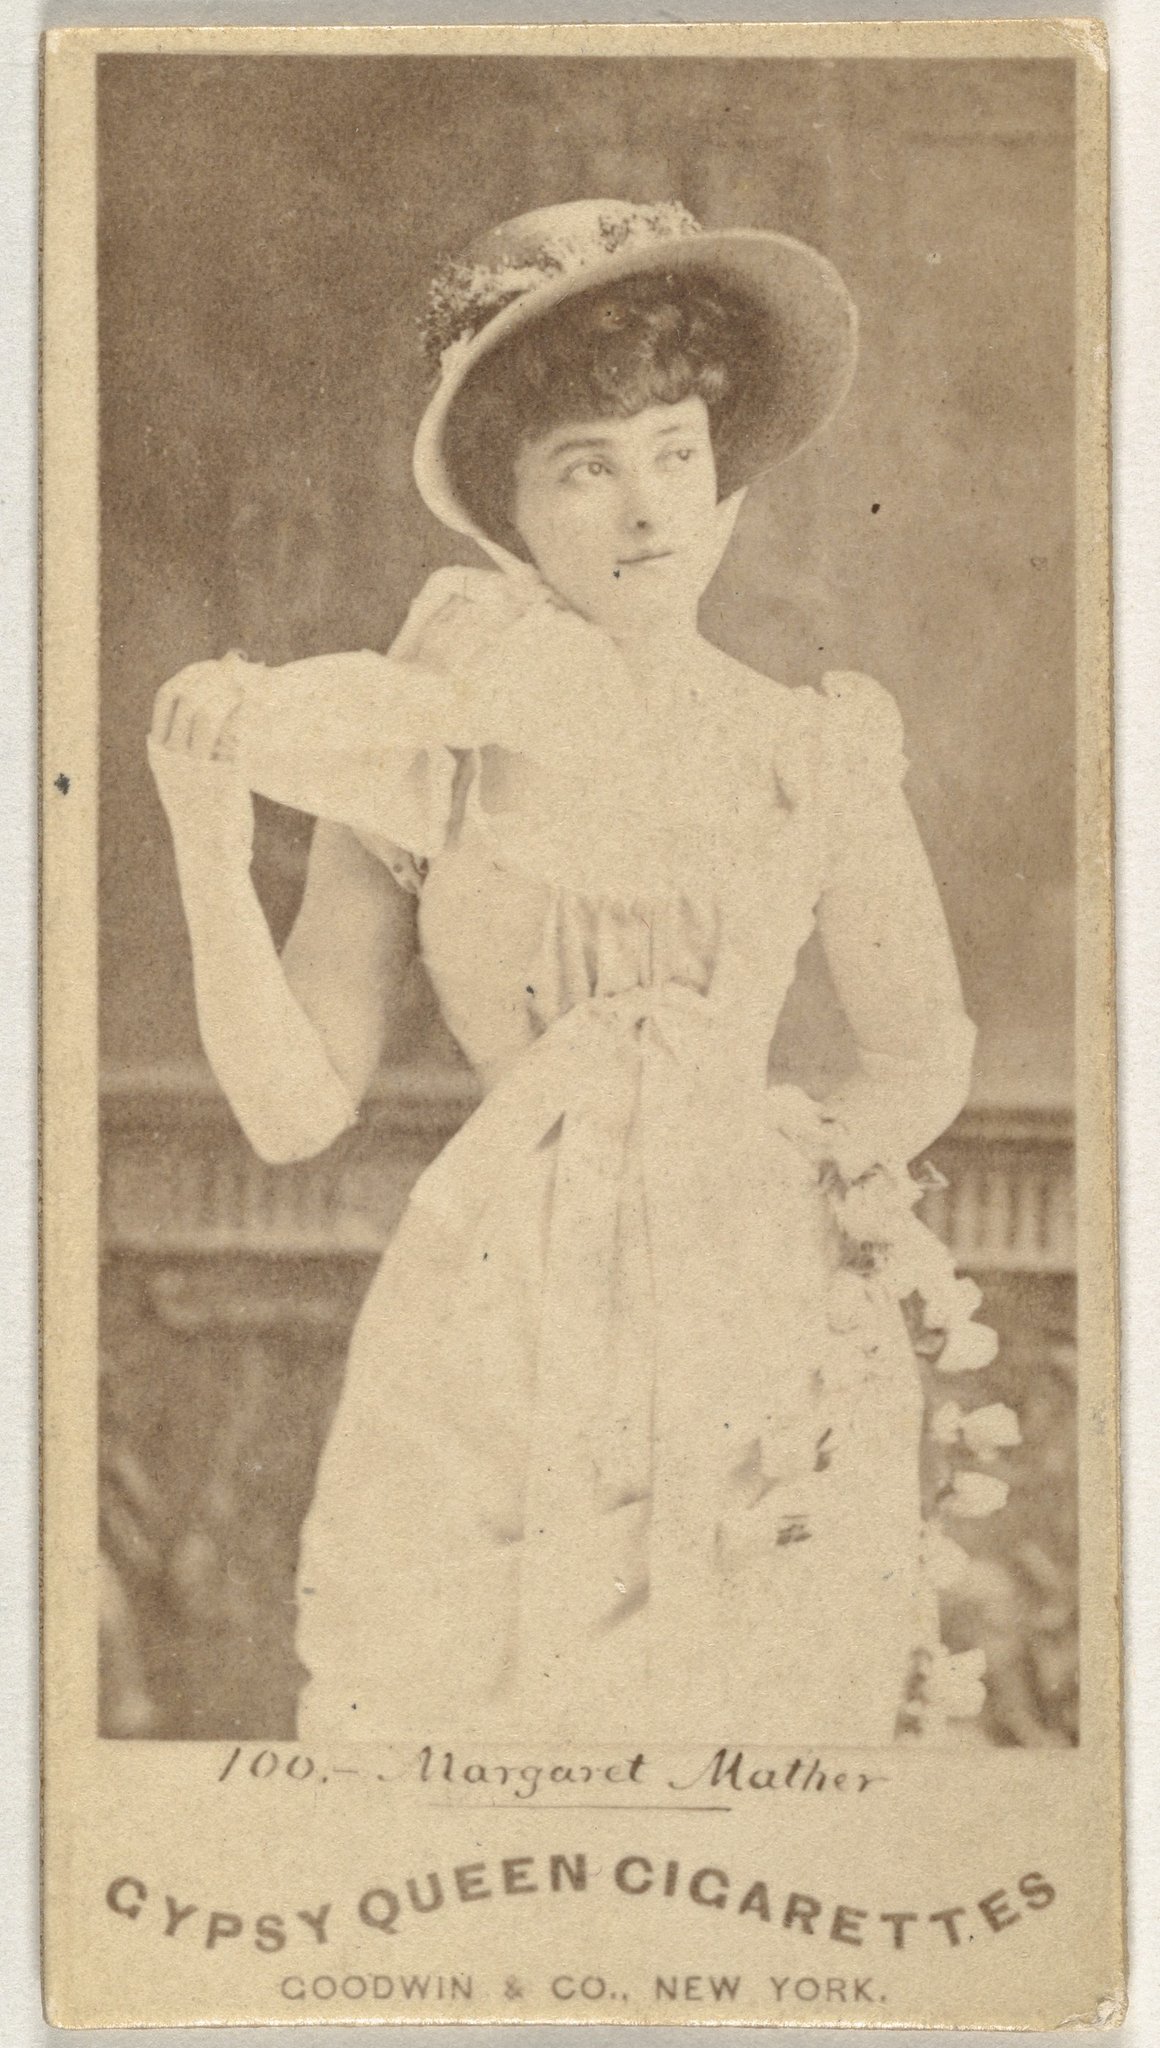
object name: photograph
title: Margaret Mather, from the Actors and Actresses series (N171) for Gypsy Queen Cigarettes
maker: goodwin & company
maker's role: publisher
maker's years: 1850-1950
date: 1886-1890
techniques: albumen silver print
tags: portraits,women,actresses